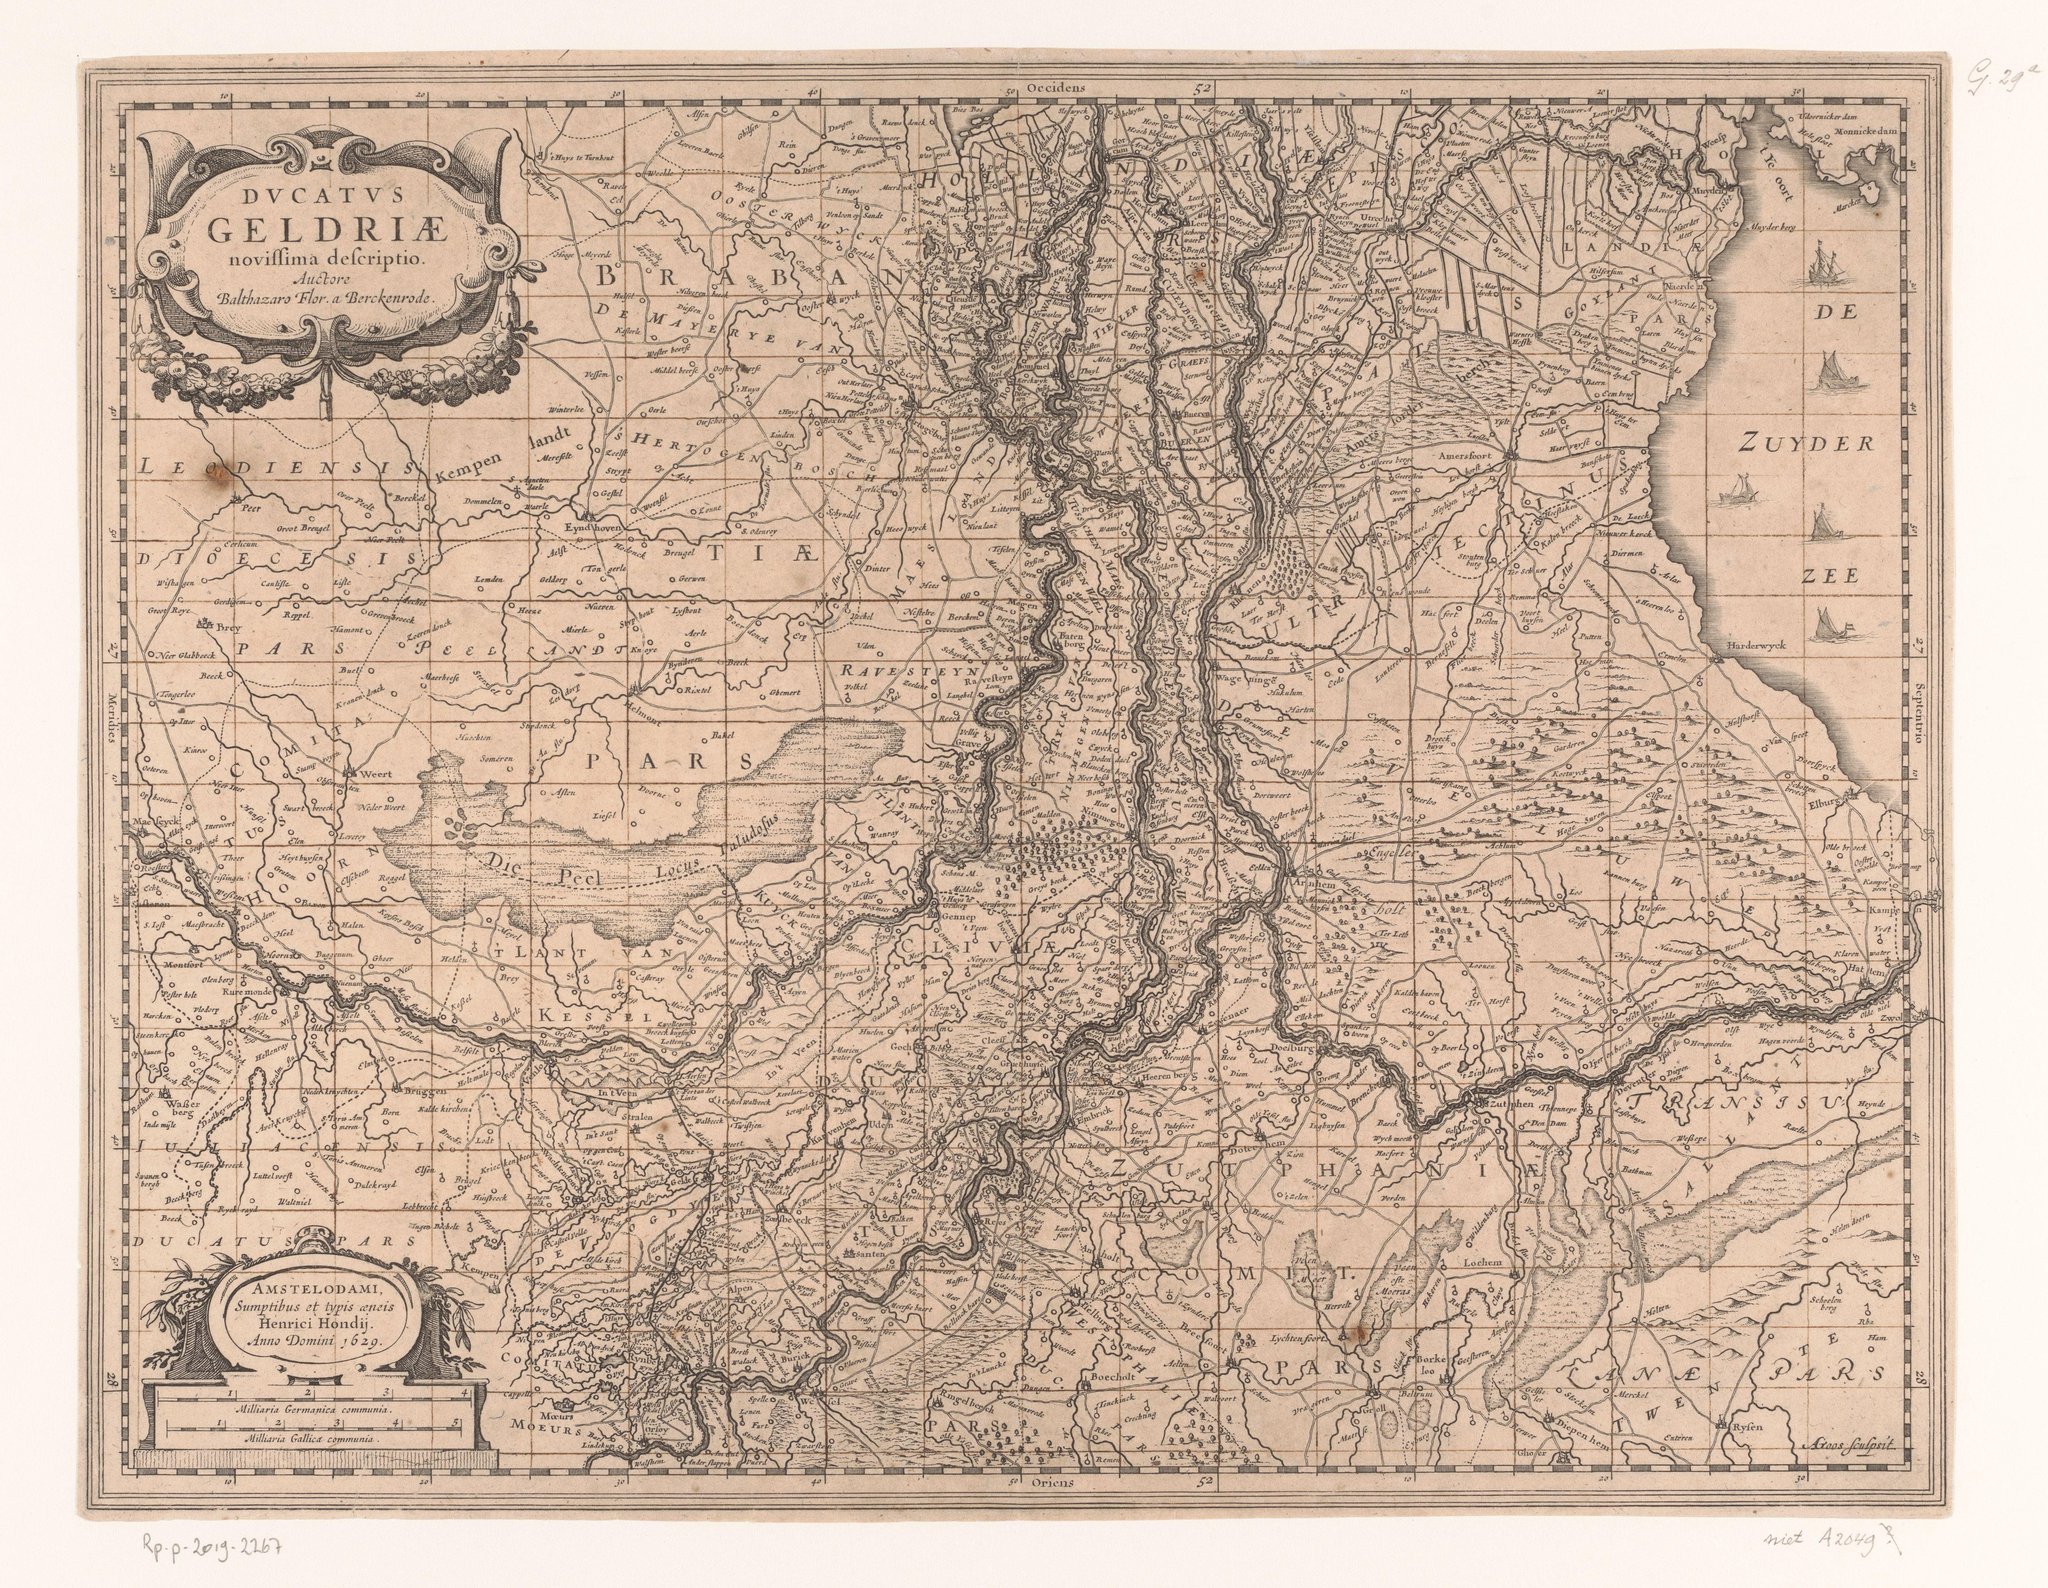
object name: map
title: Ducatus Geldriae novissima descriptio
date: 1629-1632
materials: ink, paper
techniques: engraving, etching, pen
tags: maps of separate countries or regions, gelderland, guelders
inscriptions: collector's mark: Lugt 2228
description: Linksboven de titelcartouche. Linksonder een cartouche met twee schaalstokken: 4 Milliaria Germanica communia / 5 Milliaria Gallica communia. De kaart is voorzien van een rooster en een gradenverdeling langs de randen.